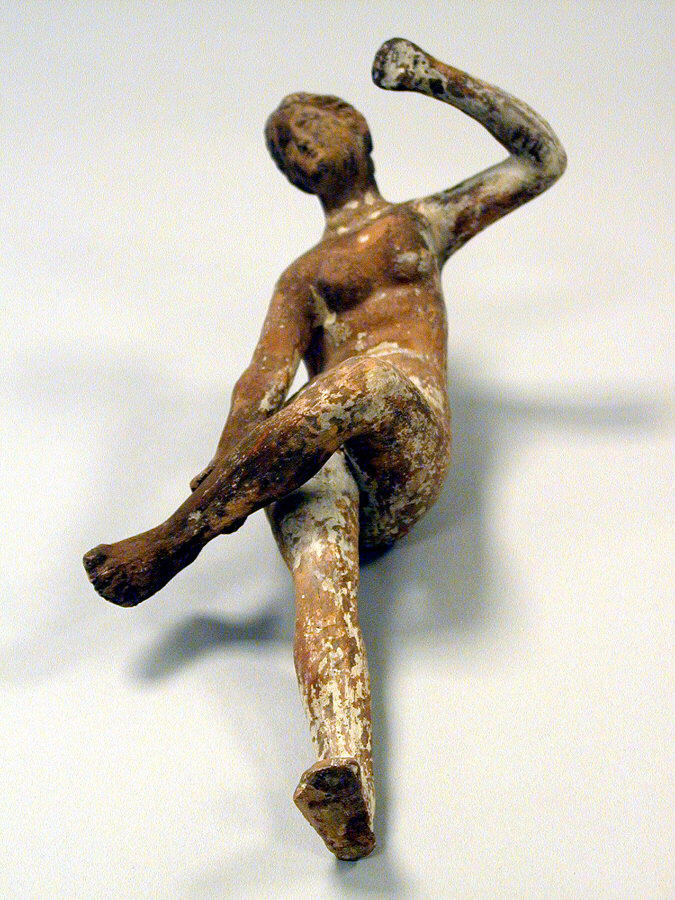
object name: statuette of aphrodite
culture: greek or south italian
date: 300-101 BCE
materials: terracotta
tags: aphrodite